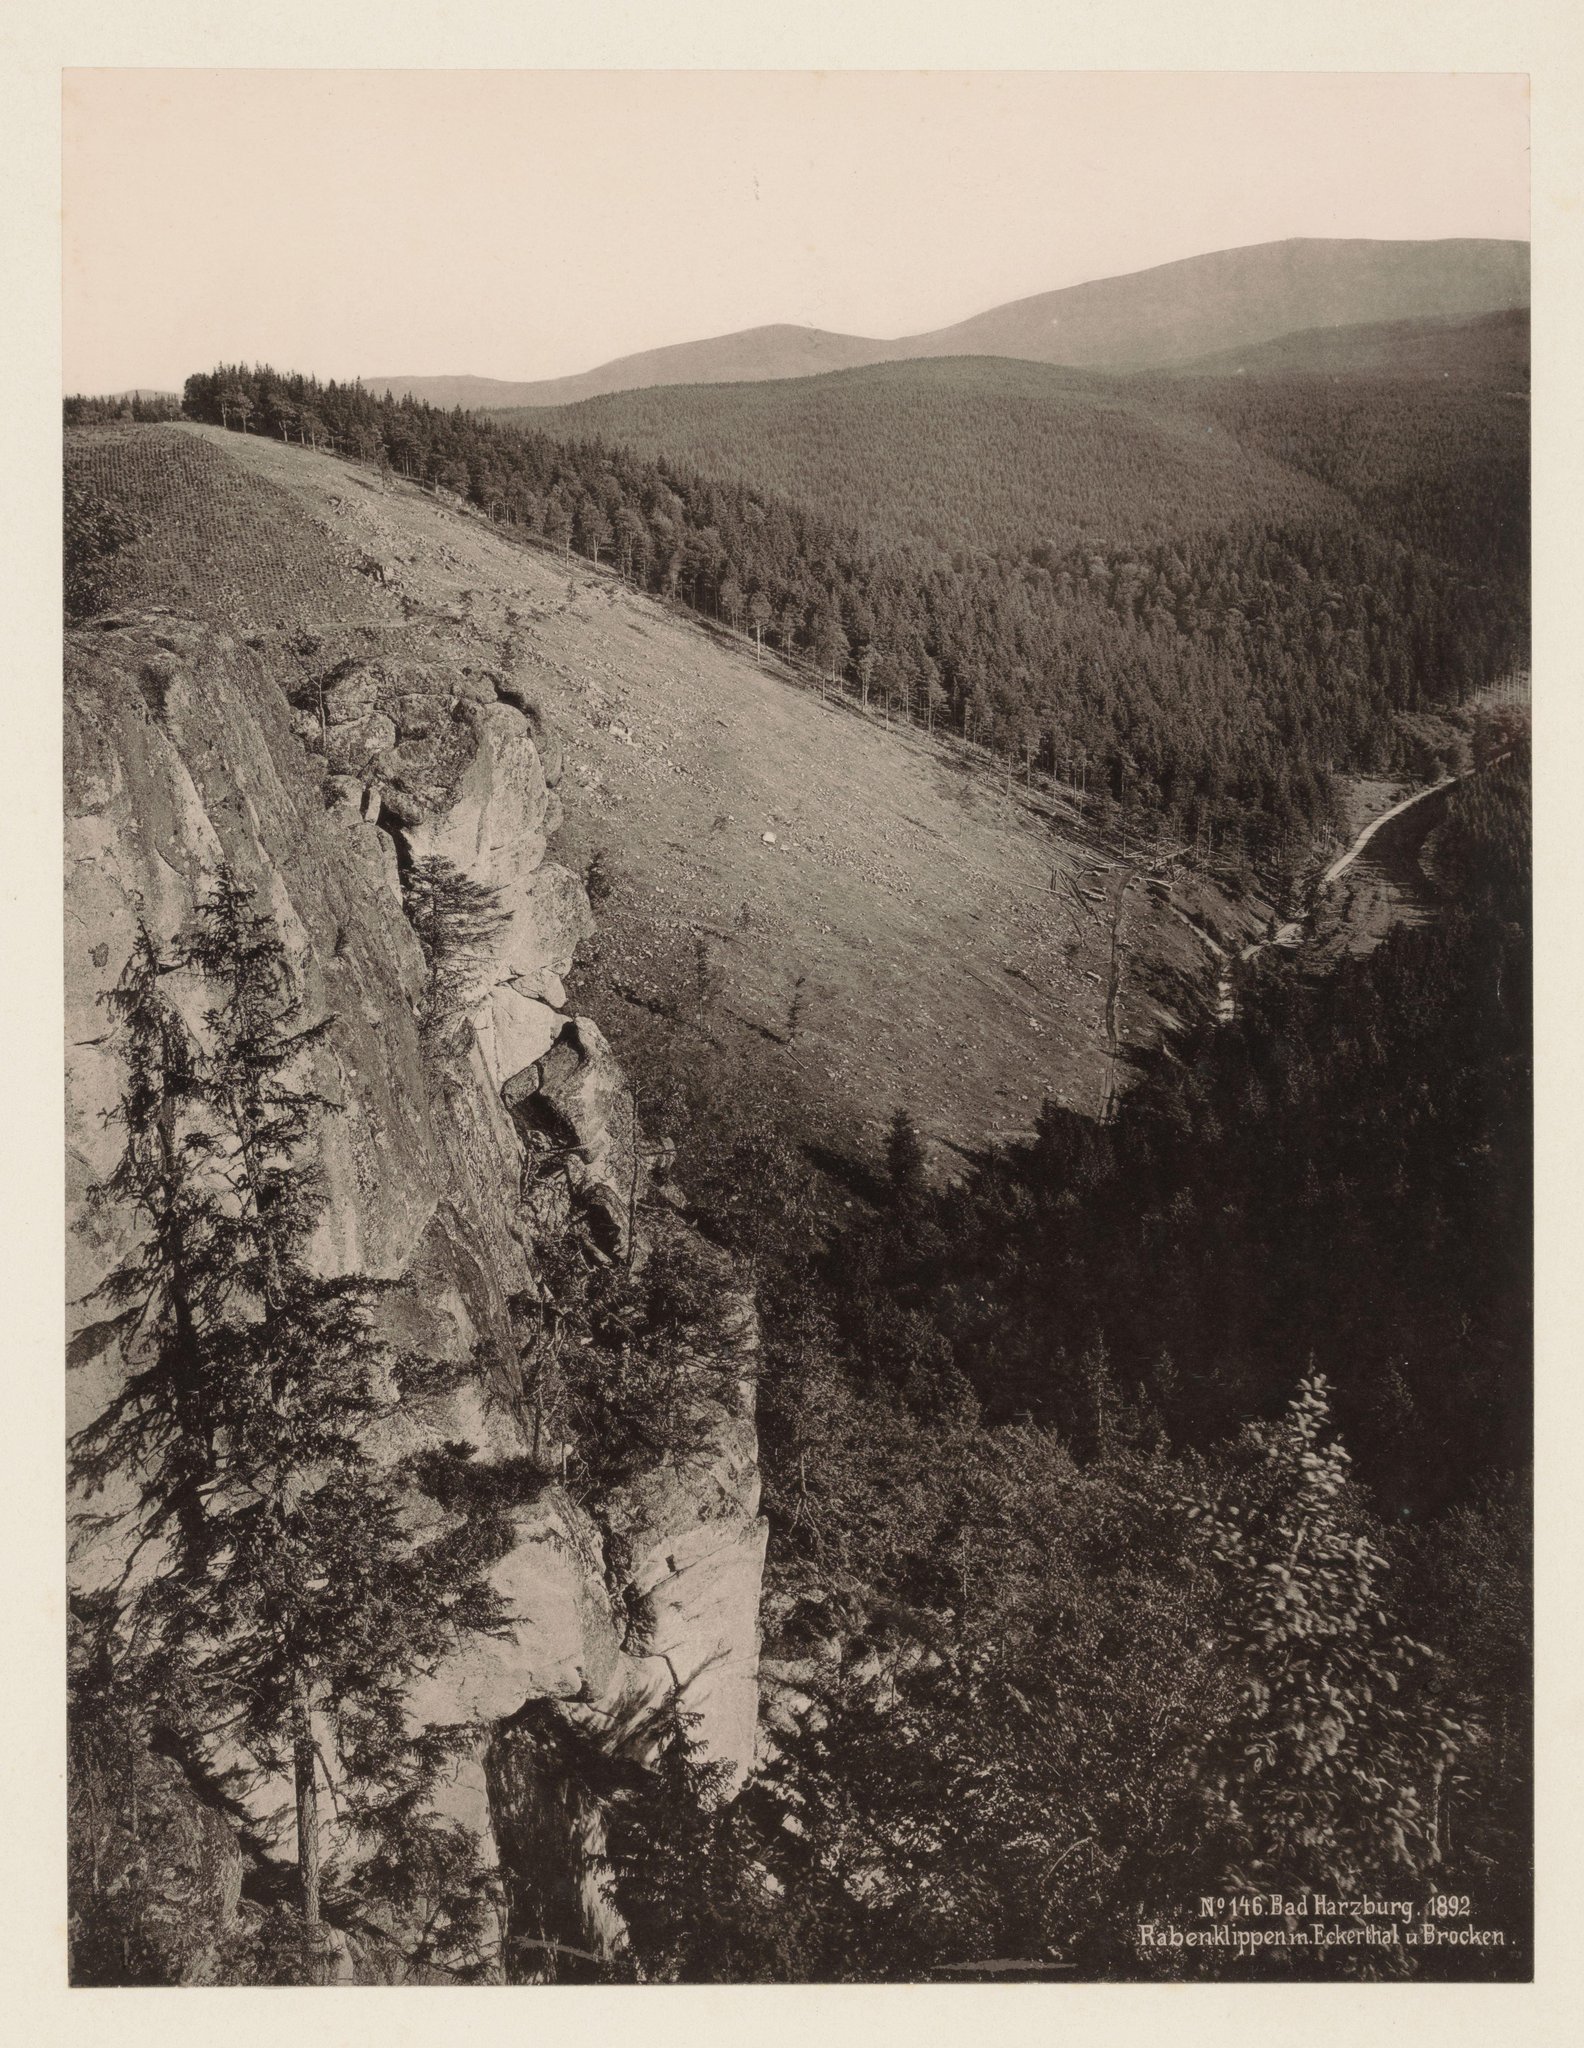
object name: photomechanical print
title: Zicht over het Eckerdal met de Rabenklippe in de Harz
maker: Anonymous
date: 1892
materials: cardboard, paper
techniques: photograph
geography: harz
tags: dale, valley, ravine, chasm, abyss, canyon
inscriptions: number: ‘No. 146.’